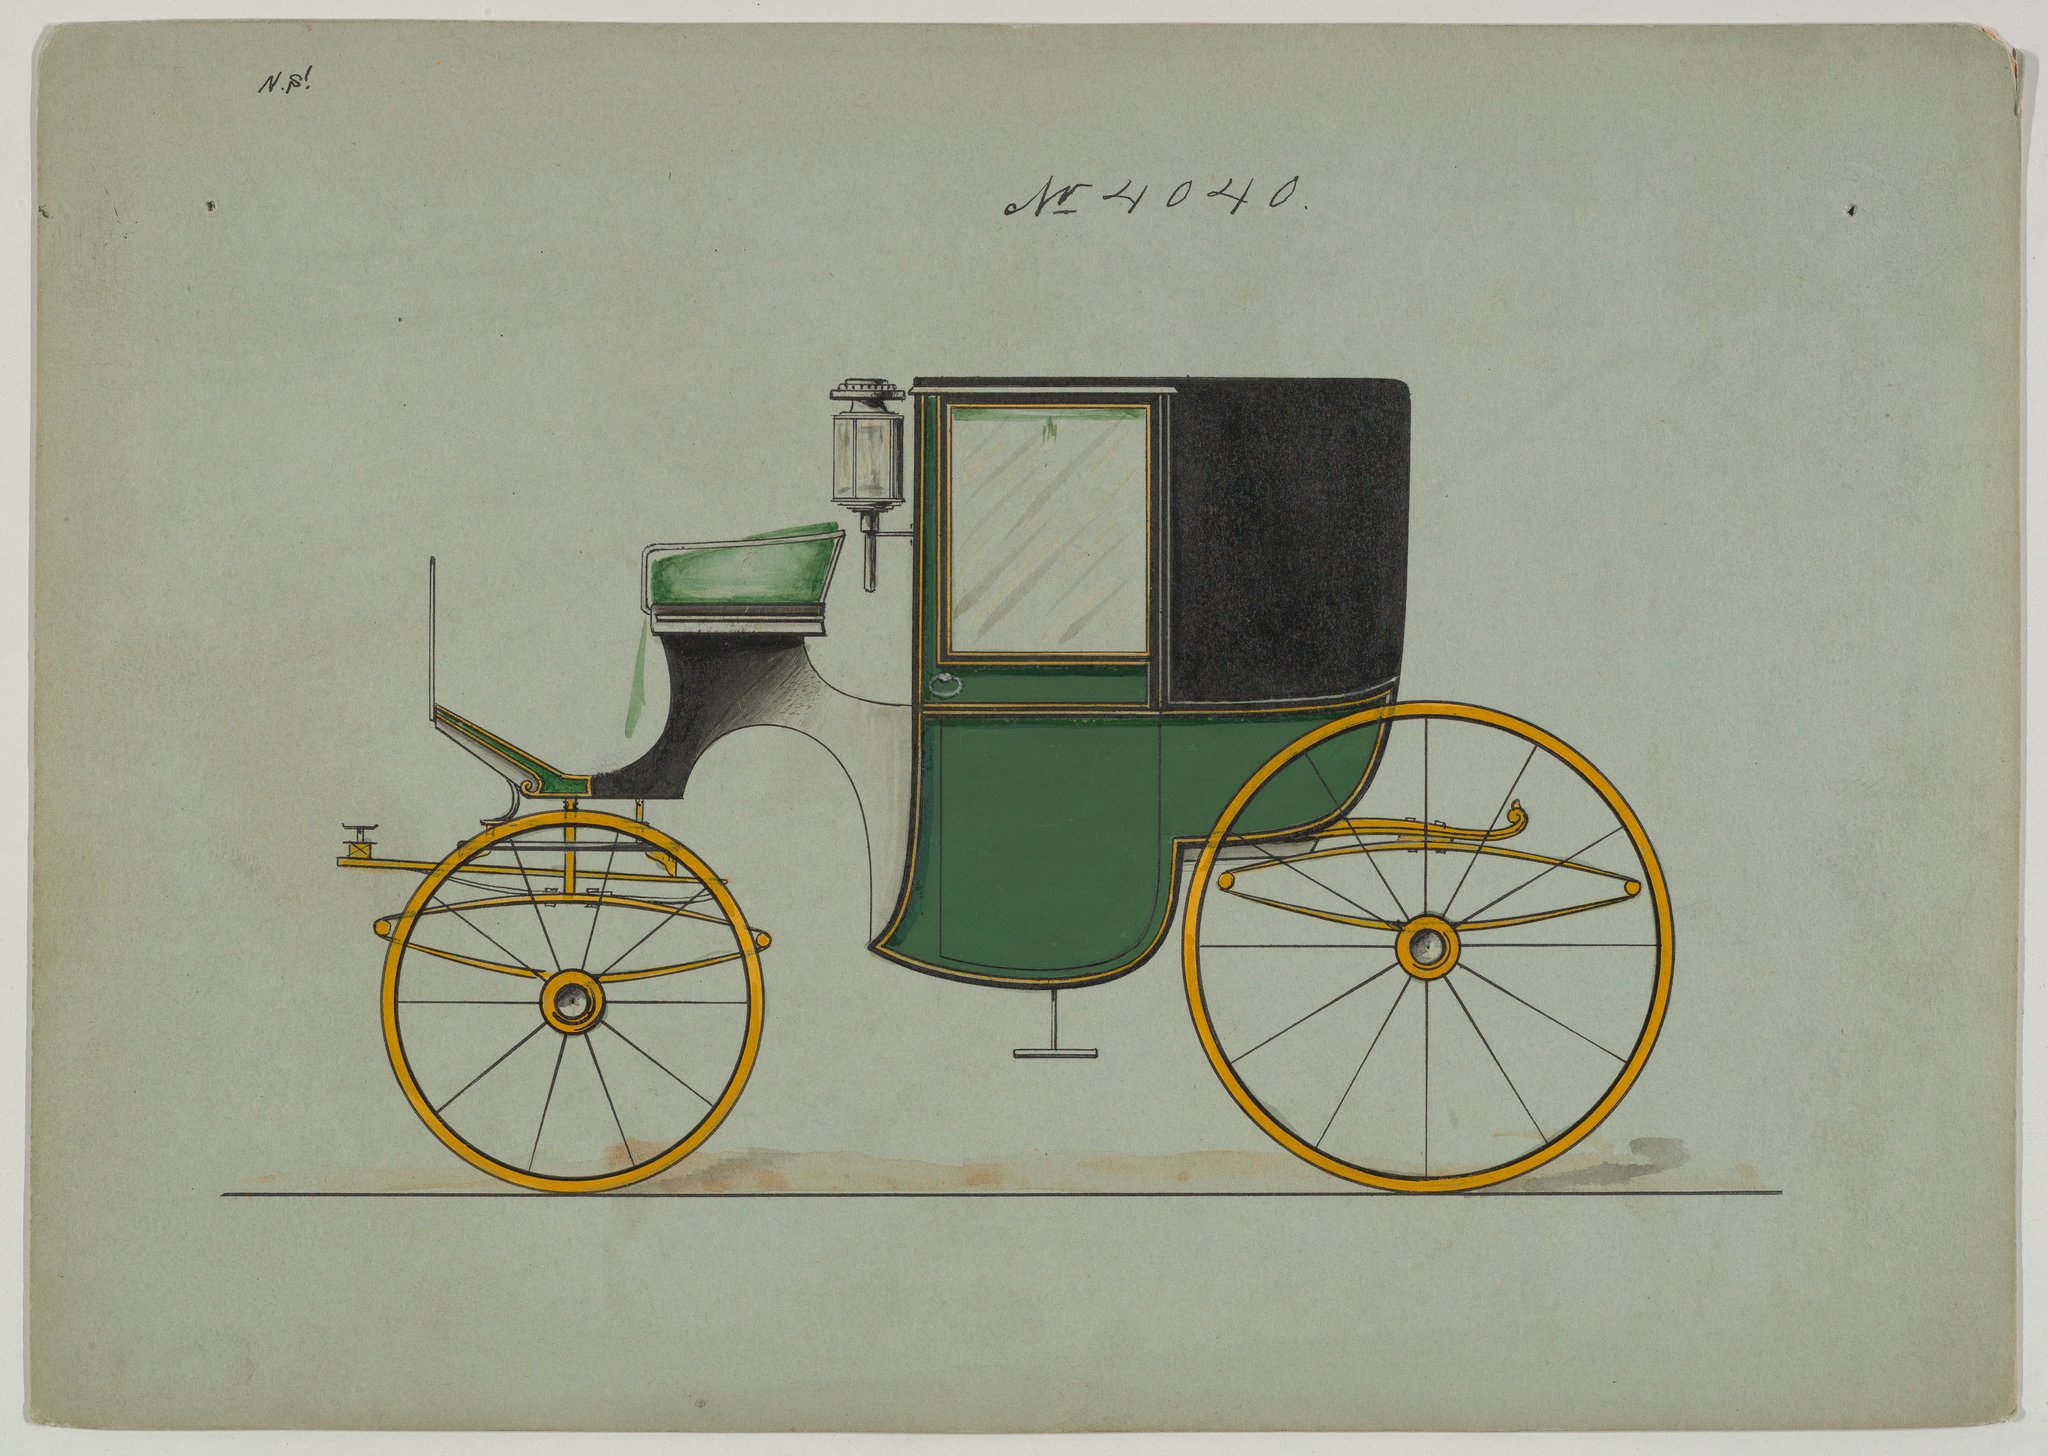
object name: drawing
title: Brougham #4040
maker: brewster & co.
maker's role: manufacturer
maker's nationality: american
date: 1889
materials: gouache, gum arabic, ink, watercolor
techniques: pen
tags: carriages